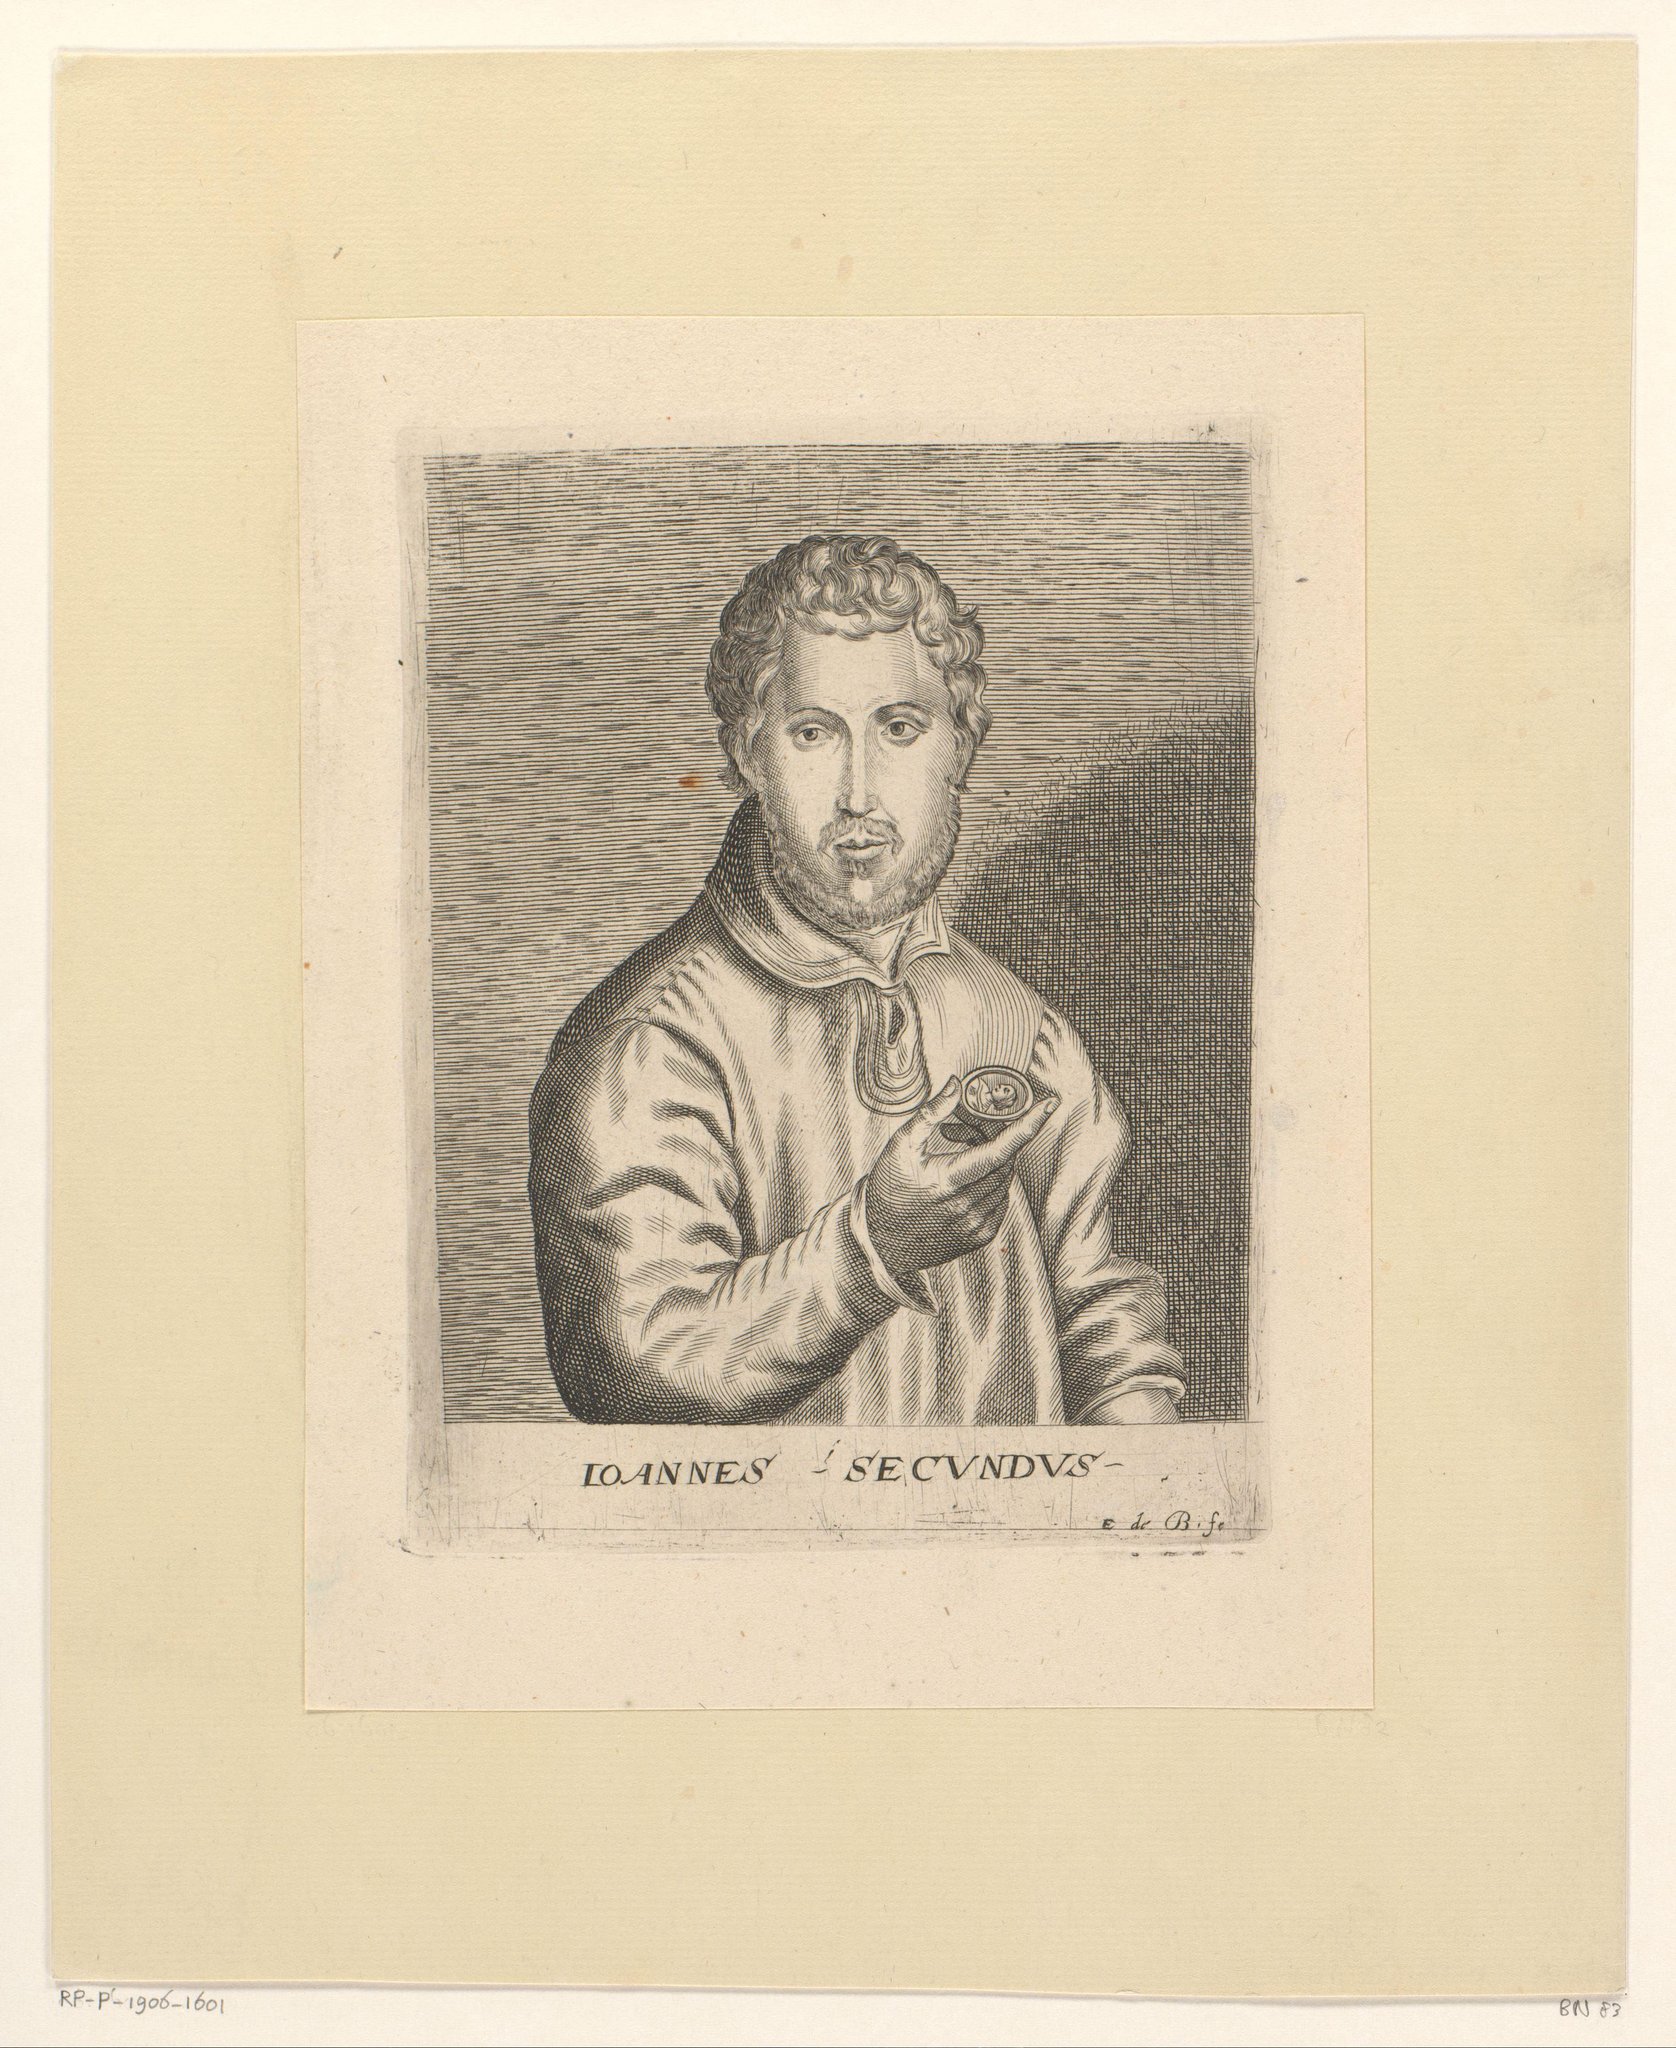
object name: print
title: Ioannes Secundus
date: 1682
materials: paper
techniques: engraving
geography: brussels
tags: the hague, janus secundus, historical persons, portrait of a writer, writer, poet, author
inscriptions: collector's mark: Lugt 2228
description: Prent uit: Bullert, Isaac. Académie des Sciences et Arts contenant les vies et éloges his. des hommes illustres qui ont excellé en ces professions depuis environ quatre siècles. Brussel: Foppens, François, 1682. Het boek werd in 1682 eveneens in Amsterdam uitgegeven door de erfgenamen van Daniel Elzevier. Deze portretten dienen ter illustratie van de biografie van een kunstenaar of geleerde. De meeste portretten werden door Nicolas de Larmessin vervaardigd (162), 93 door De Boulonois en een derde door ongeïdentificeerde prentmakers. Dit betreft een illustratie op p. 333, deel II.